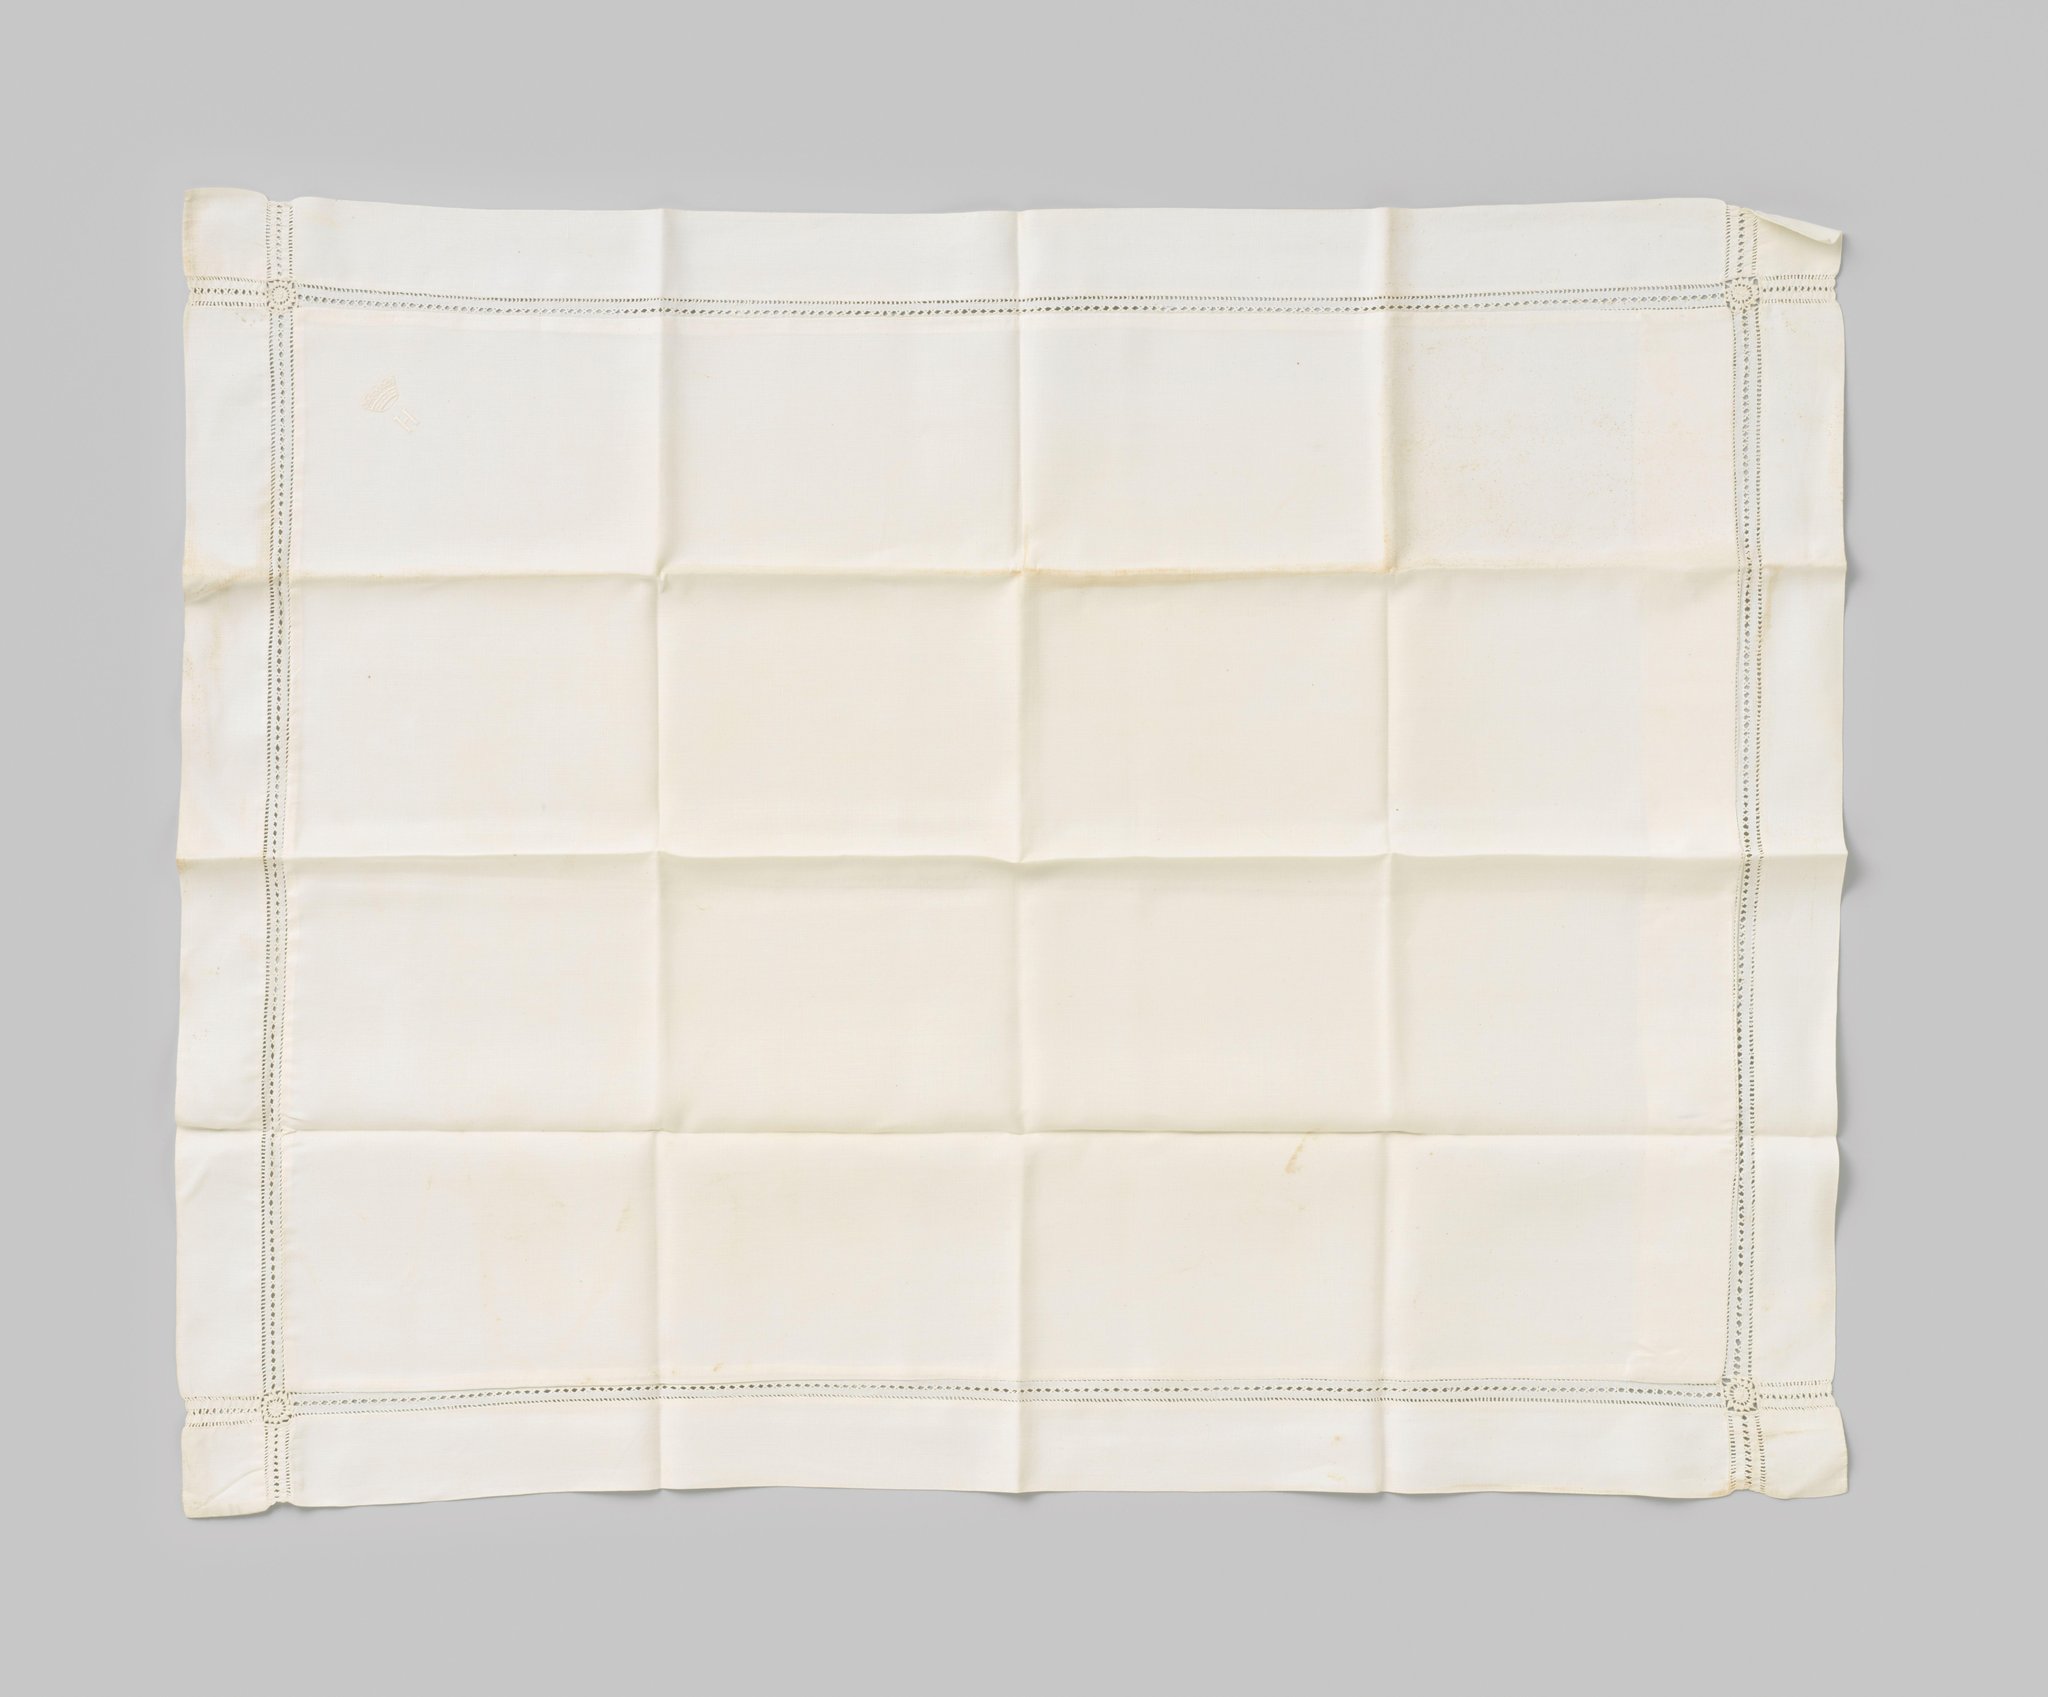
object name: sloop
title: Sloop van wit linnen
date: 1880-1920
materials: linen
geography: northern netherlands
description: Wit linnen sloop met opengewerkte randen, merk kroon H WH 2oonl.